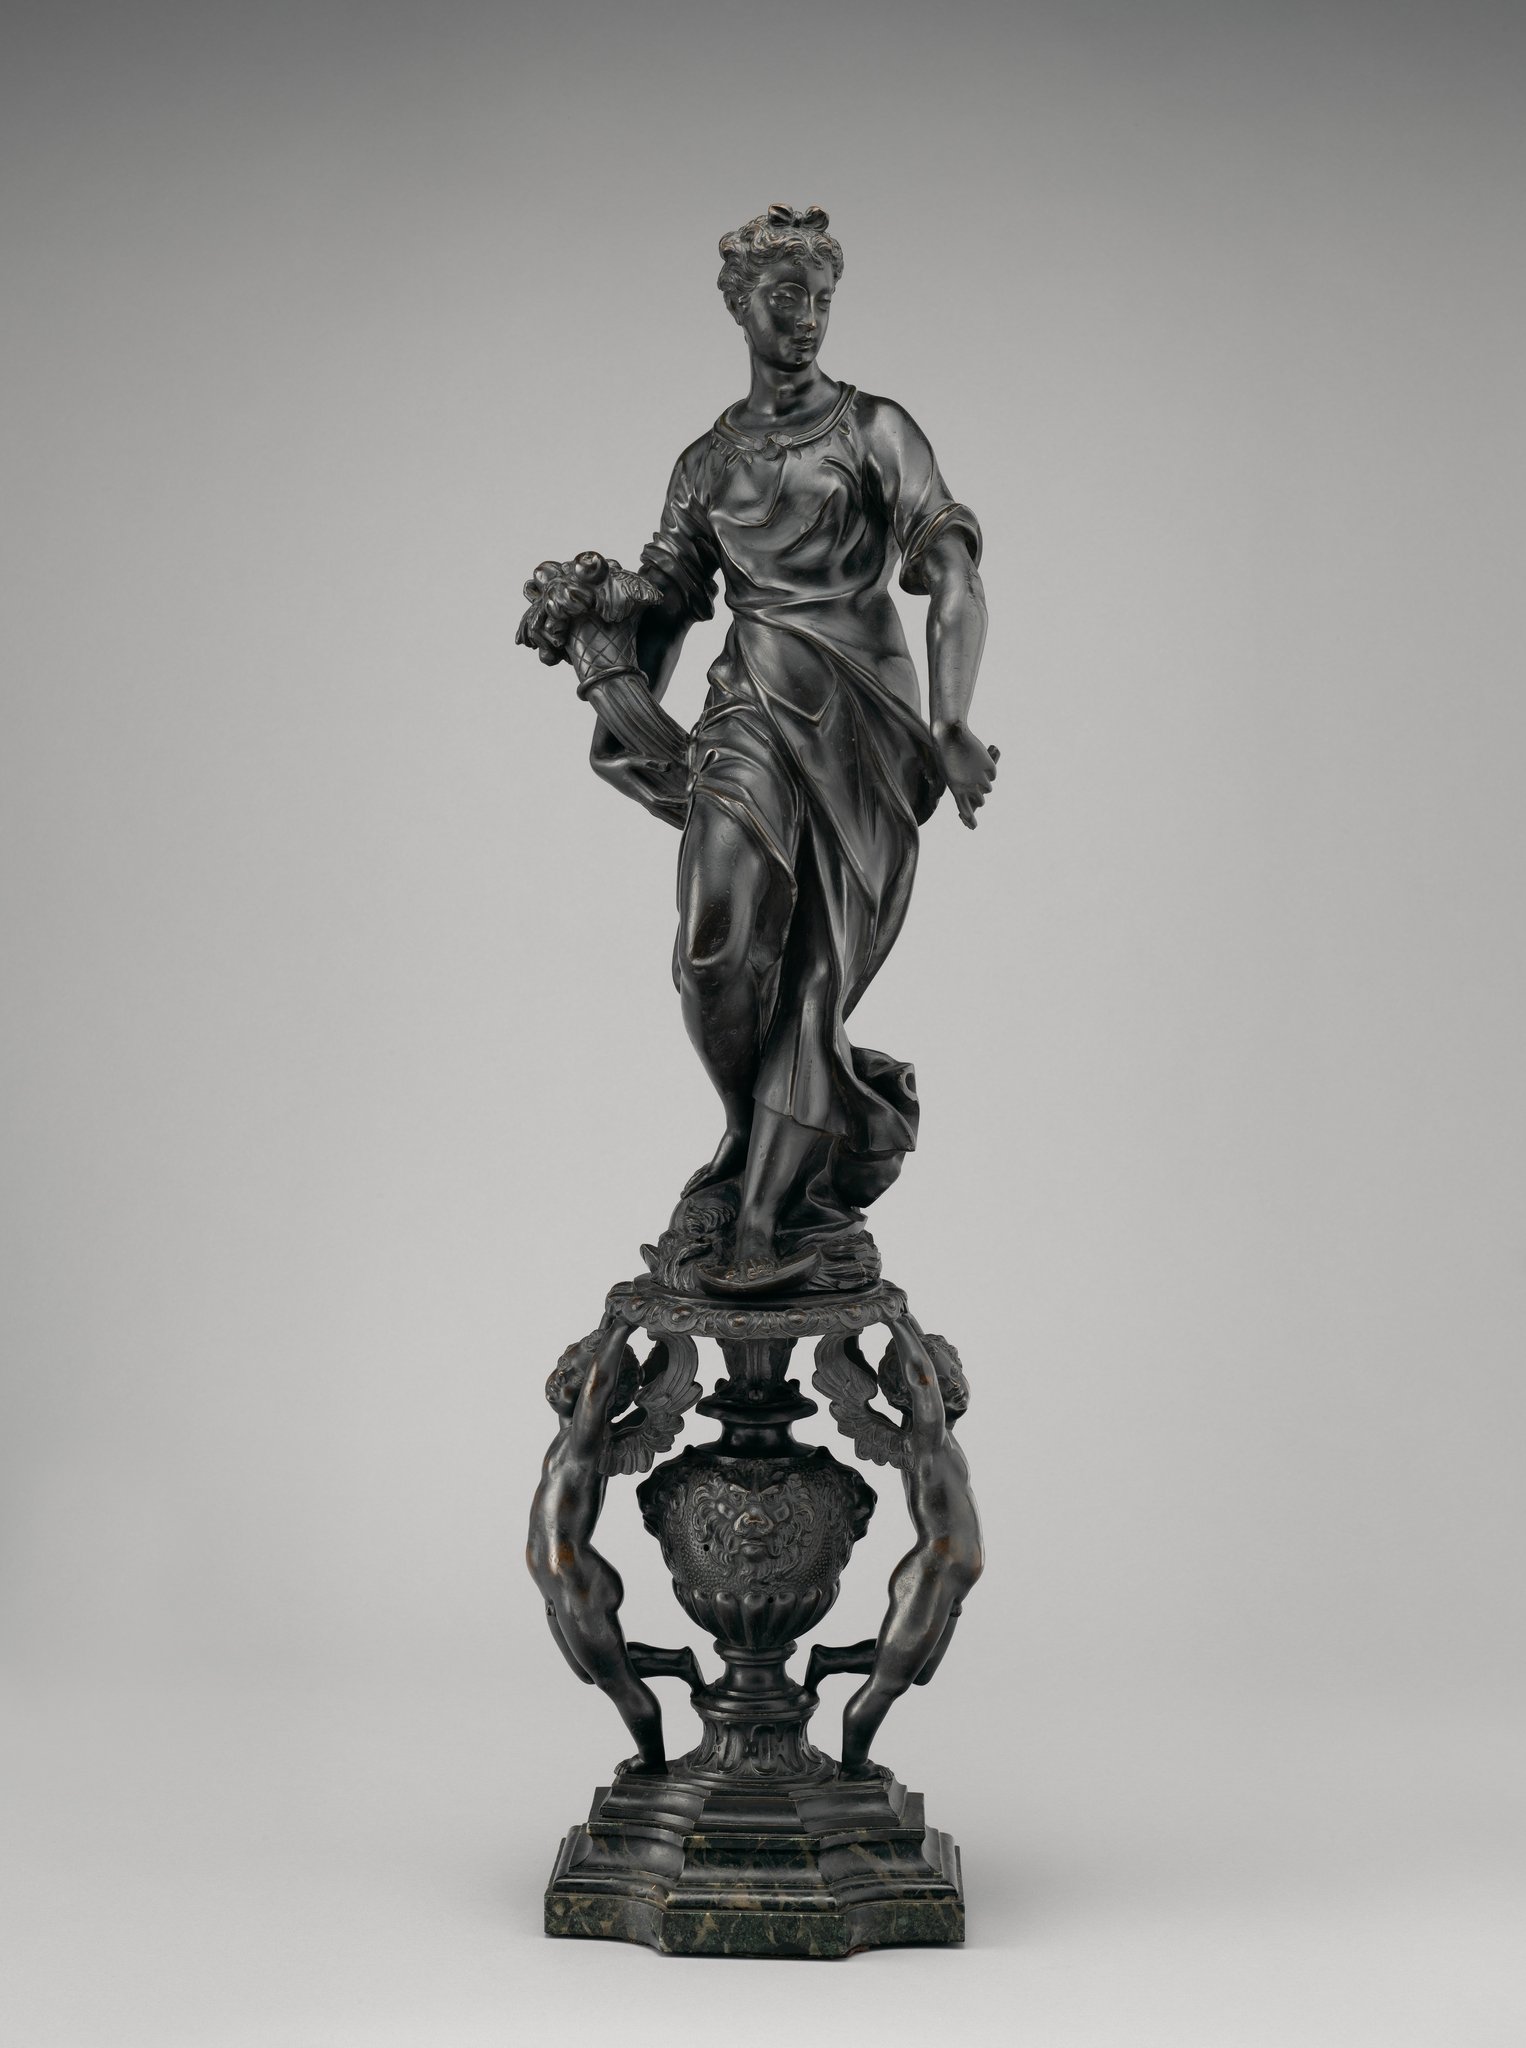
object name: andiron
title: Andiron with figure of Ceres (allegory of Peace) (one of a pair)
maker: girolamo campagna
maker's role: artist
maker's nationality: italian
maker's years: 1549-1625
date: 1601-1700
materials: bronze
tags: women,putti,cornucopia